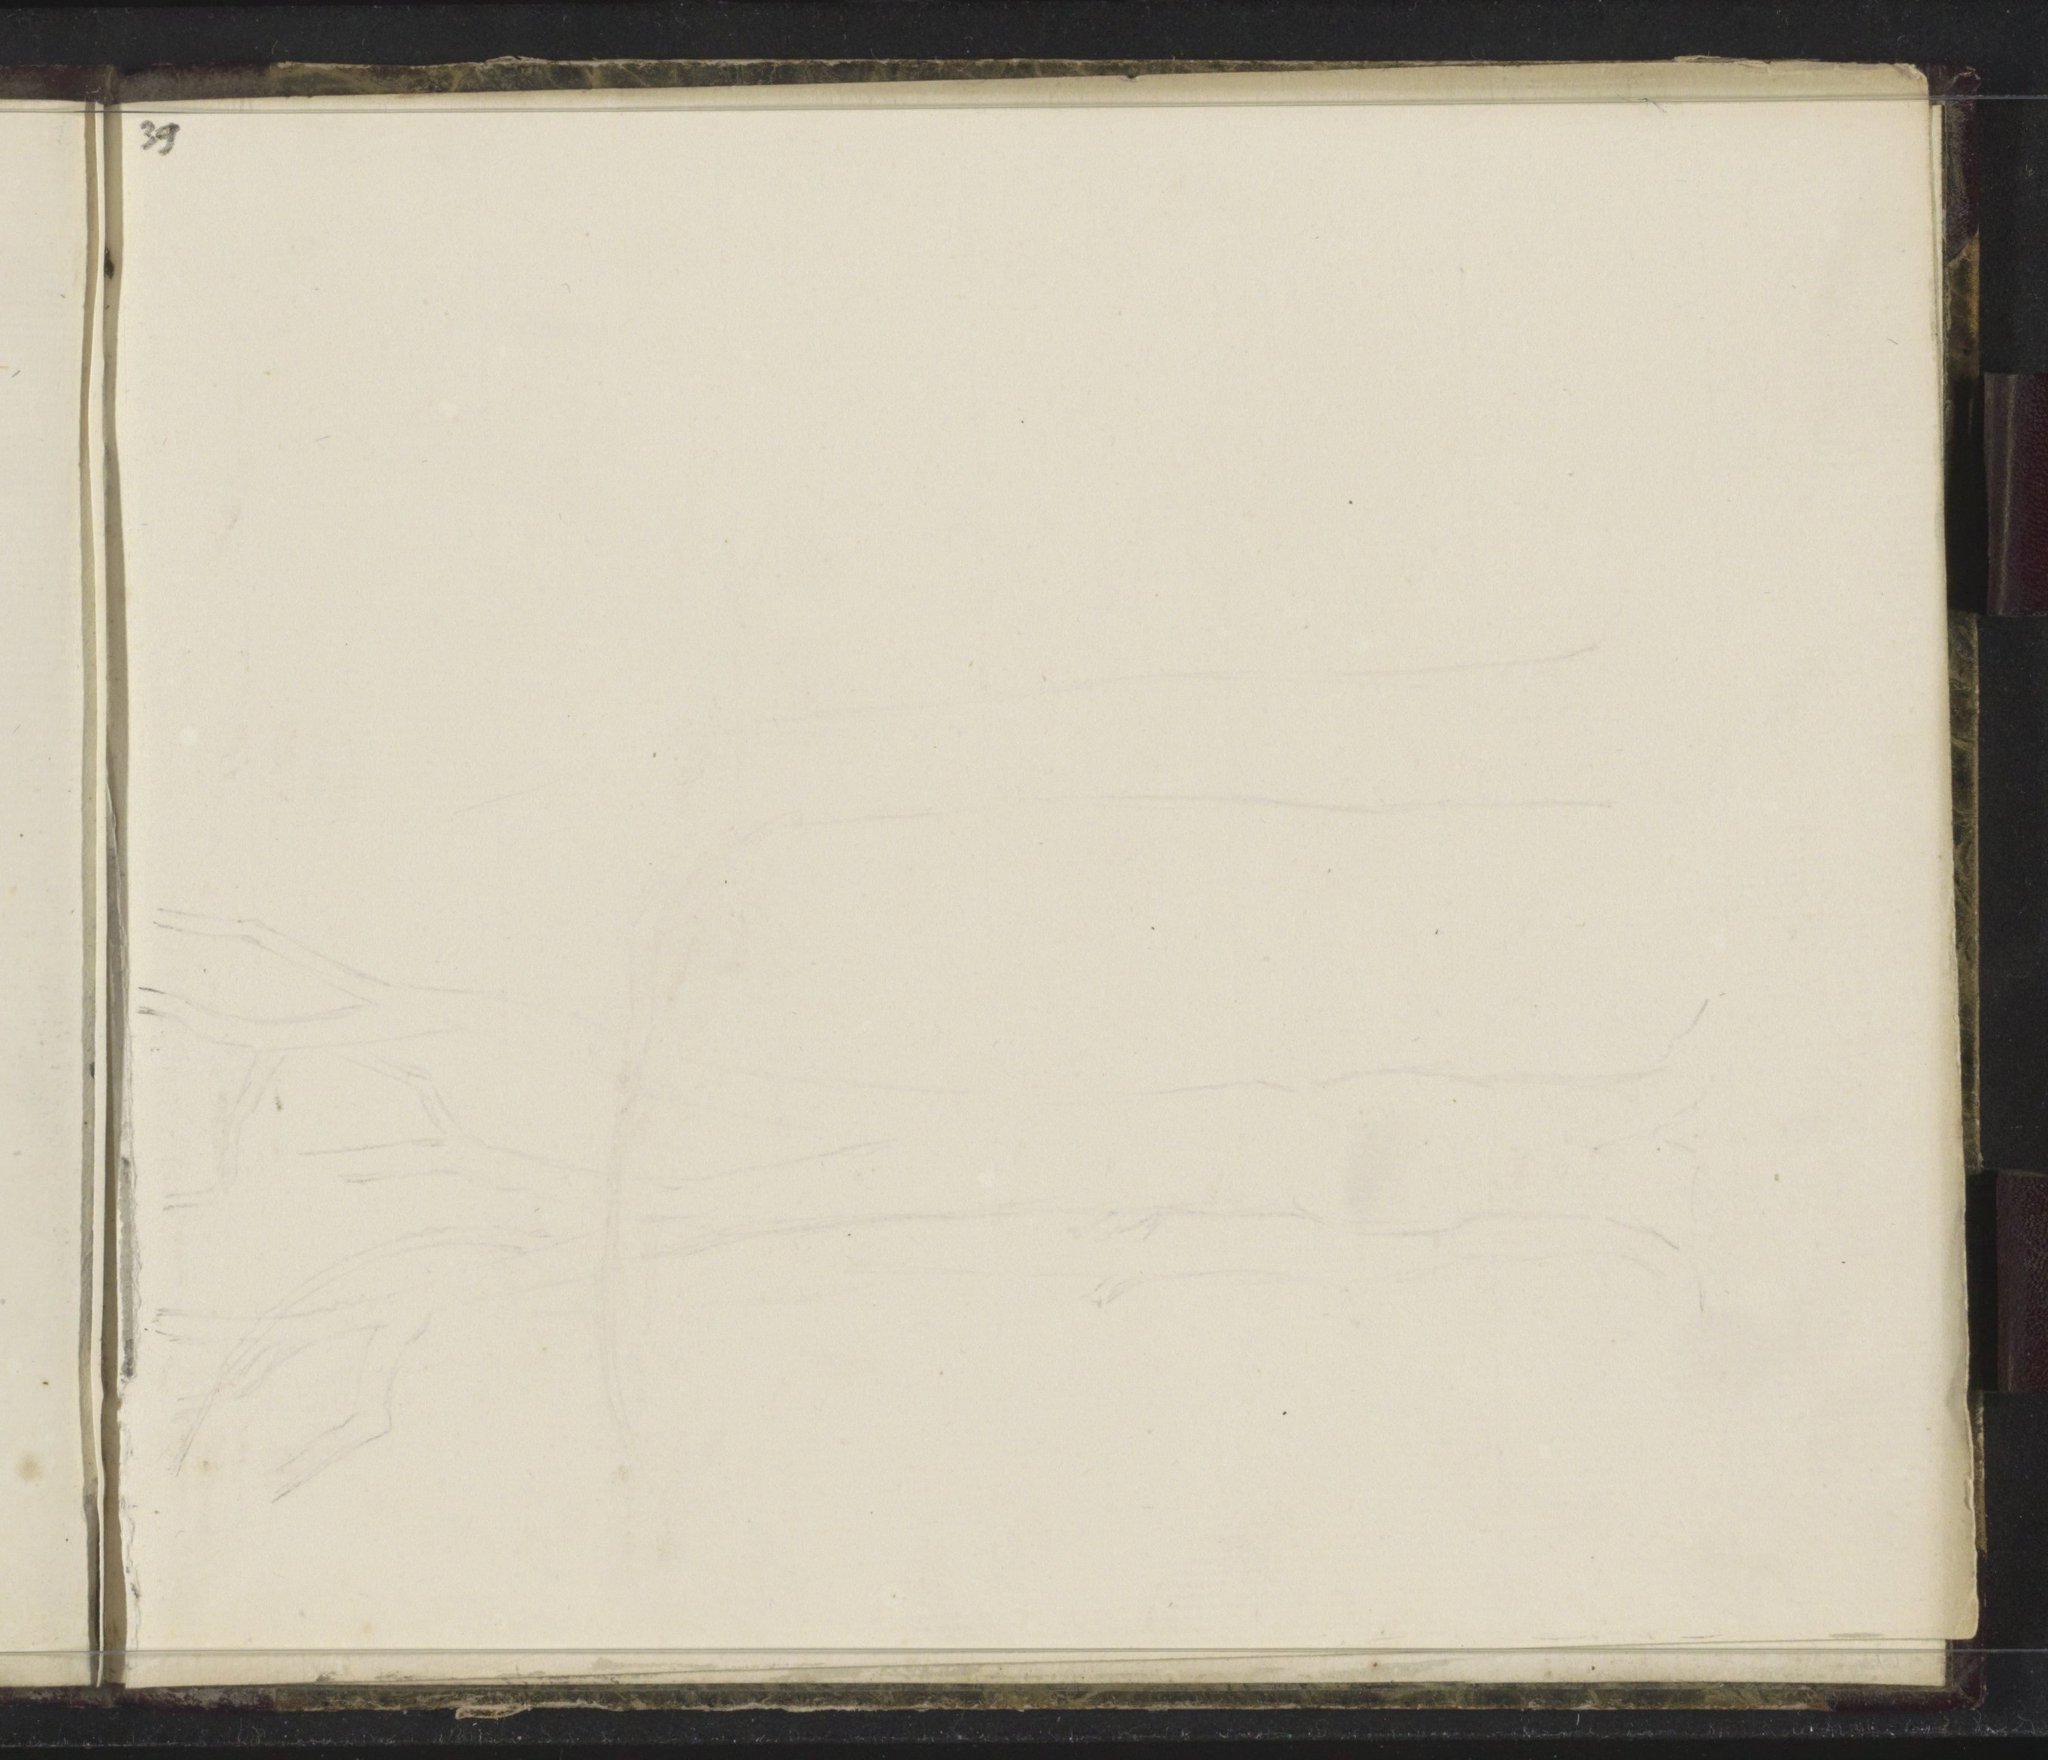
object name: sketchbook leaf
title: Bomen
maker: hendrik abraham klinkhamer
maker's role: draughtsman, painter, print maker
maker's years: 1810-1872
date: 1820-1872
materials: chalk, paper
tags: trees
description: Blad 39 recto uit een schetsboek met 39 bladen.